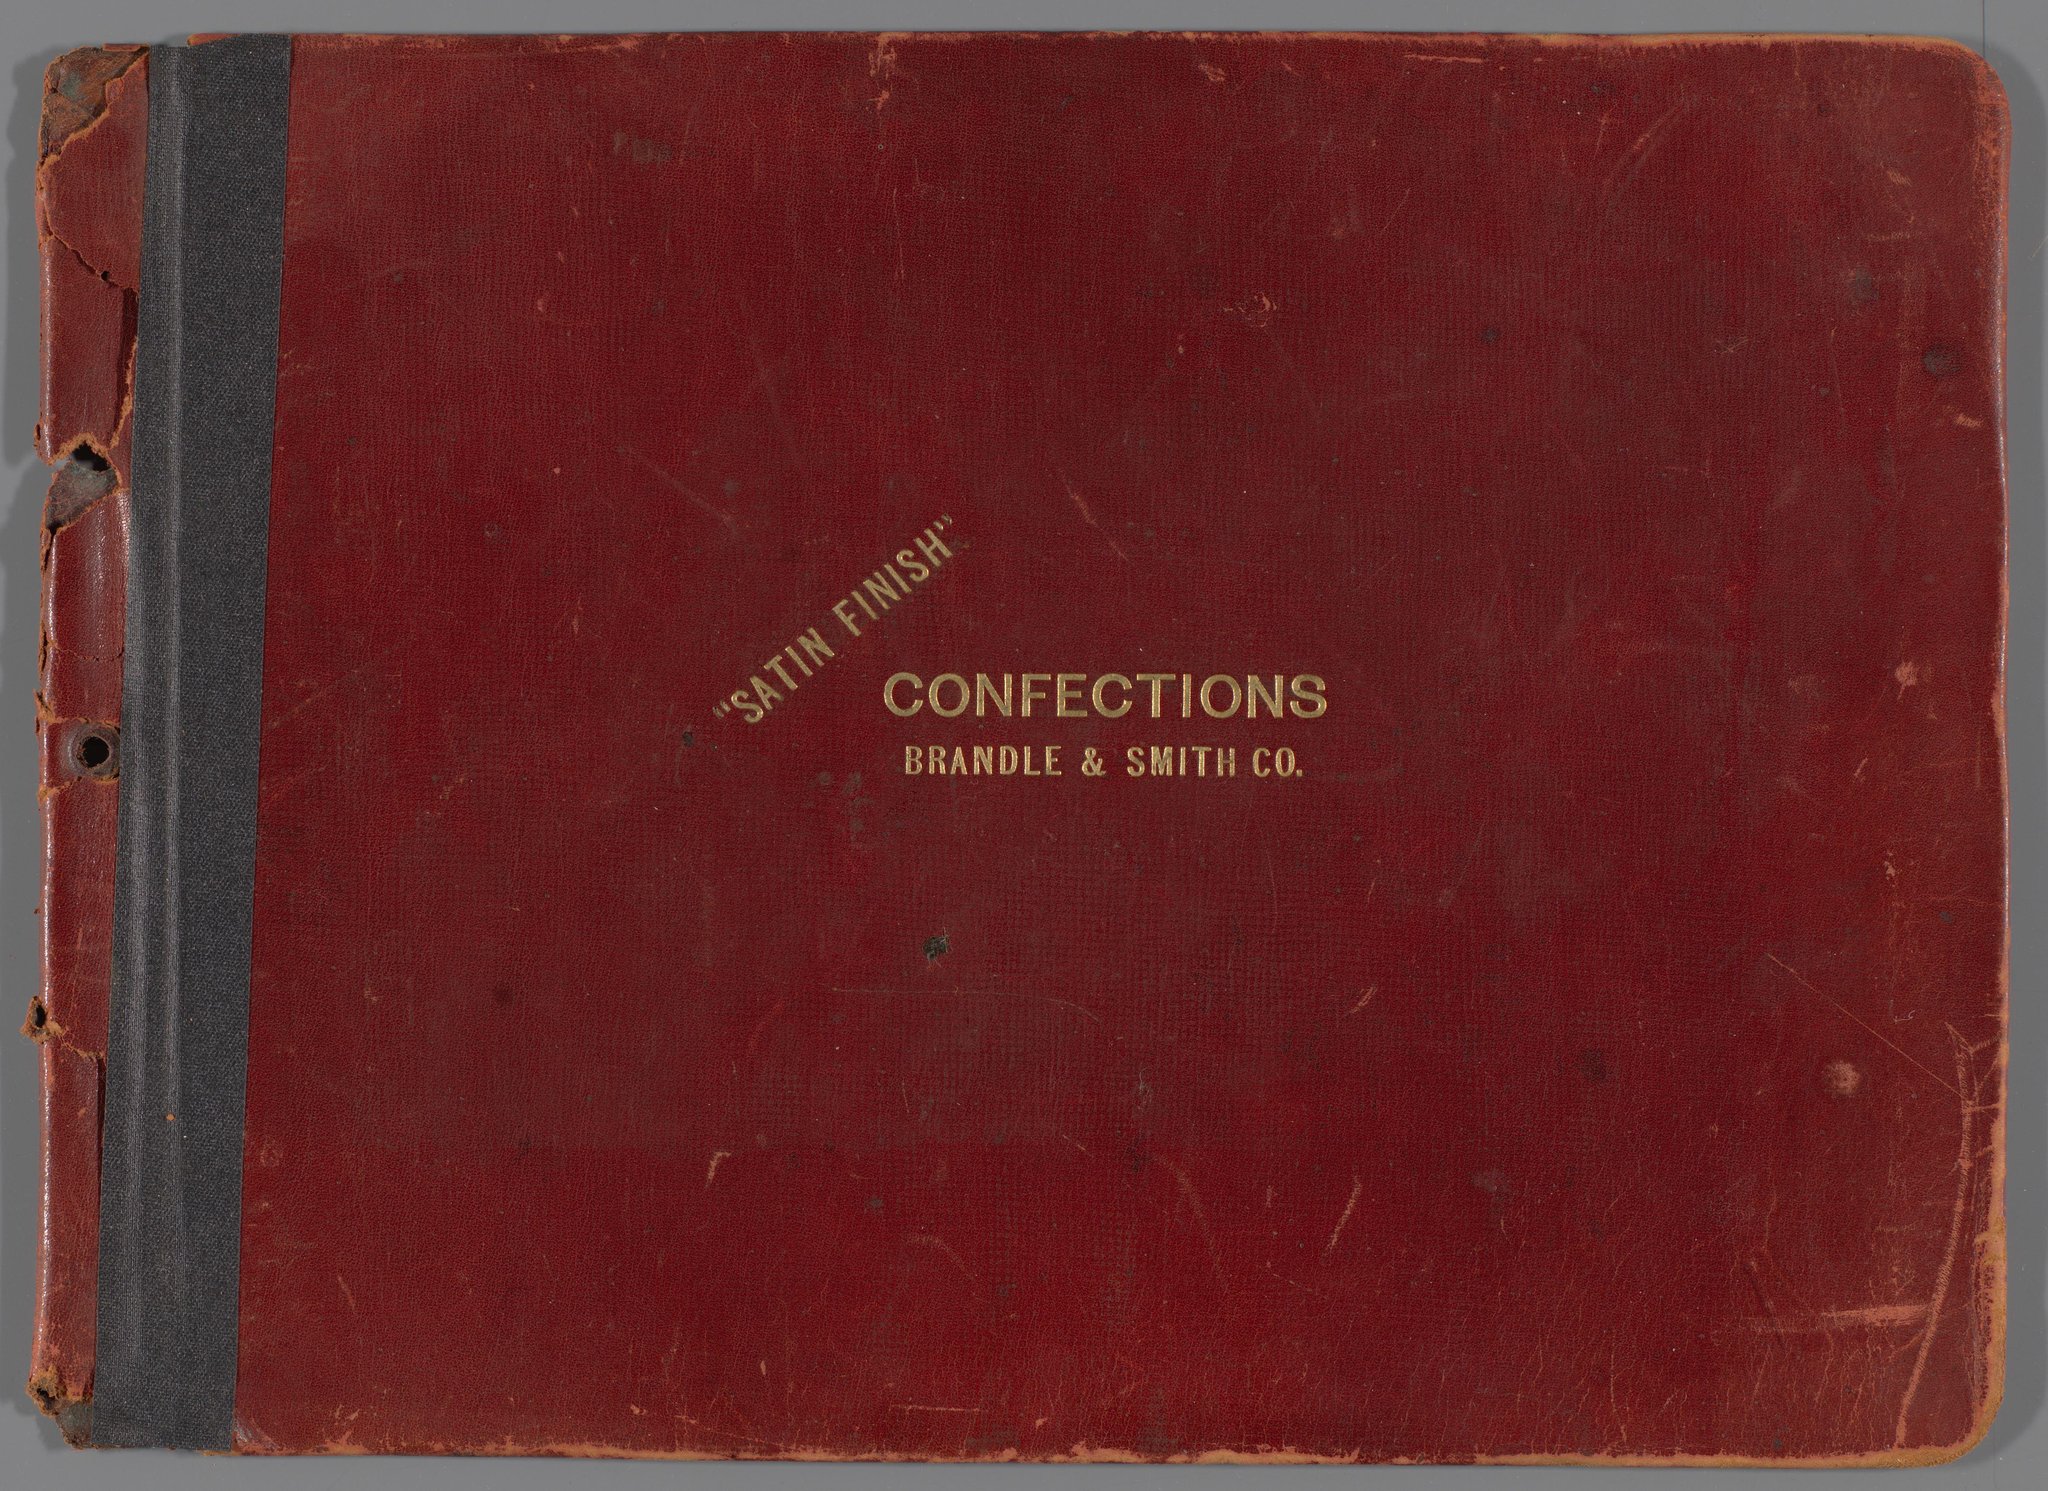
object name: wrapper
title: Confections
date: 1915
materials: cardboard, leather, textile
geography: philadelphia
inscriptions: inscription: ‘"SATIN FINISH"’